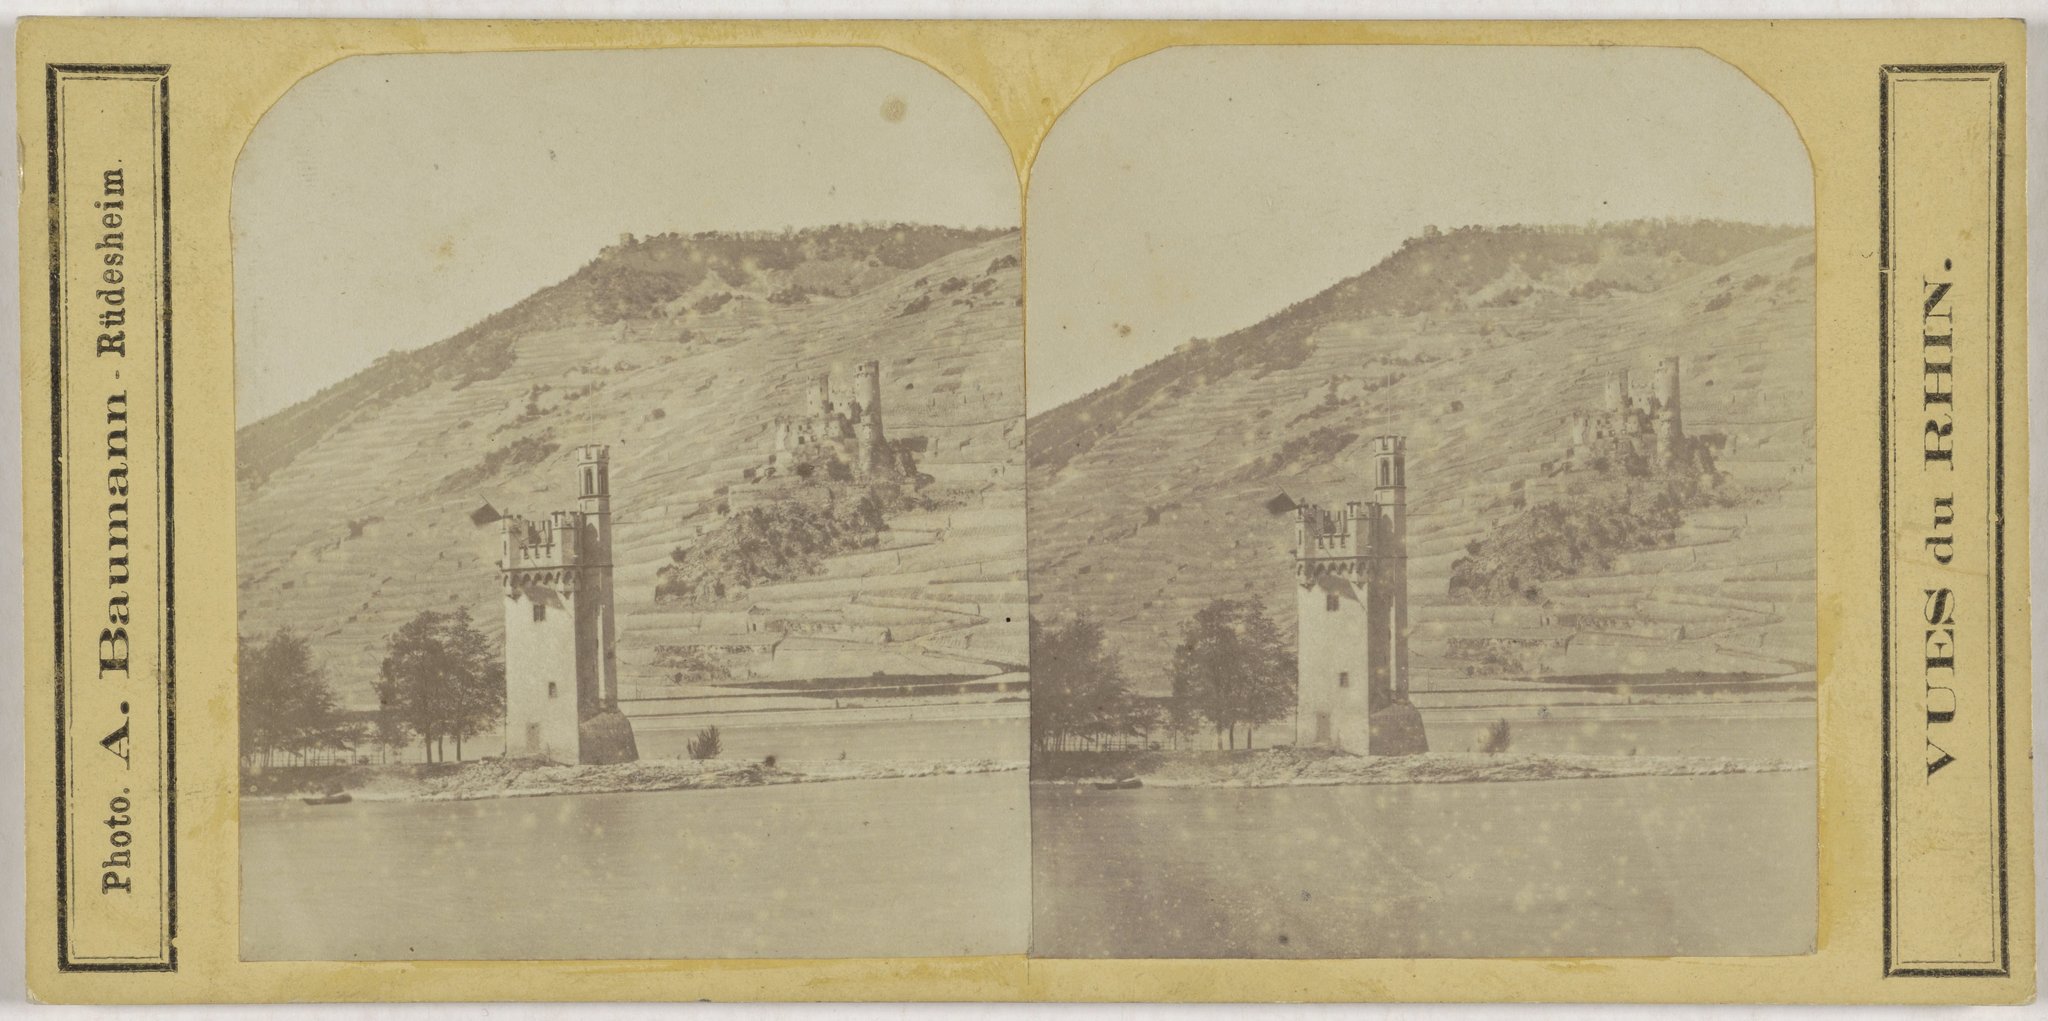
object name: stereograph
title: Muizentoren en burcht Ehrenfels nabij Bingen en Rüdesheim, Duitsland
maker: a. baumann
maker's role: publisher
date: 1861-1870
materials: cardboard, paper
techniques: albumen print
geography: rüdesheim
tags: river, landscape with tower or castle